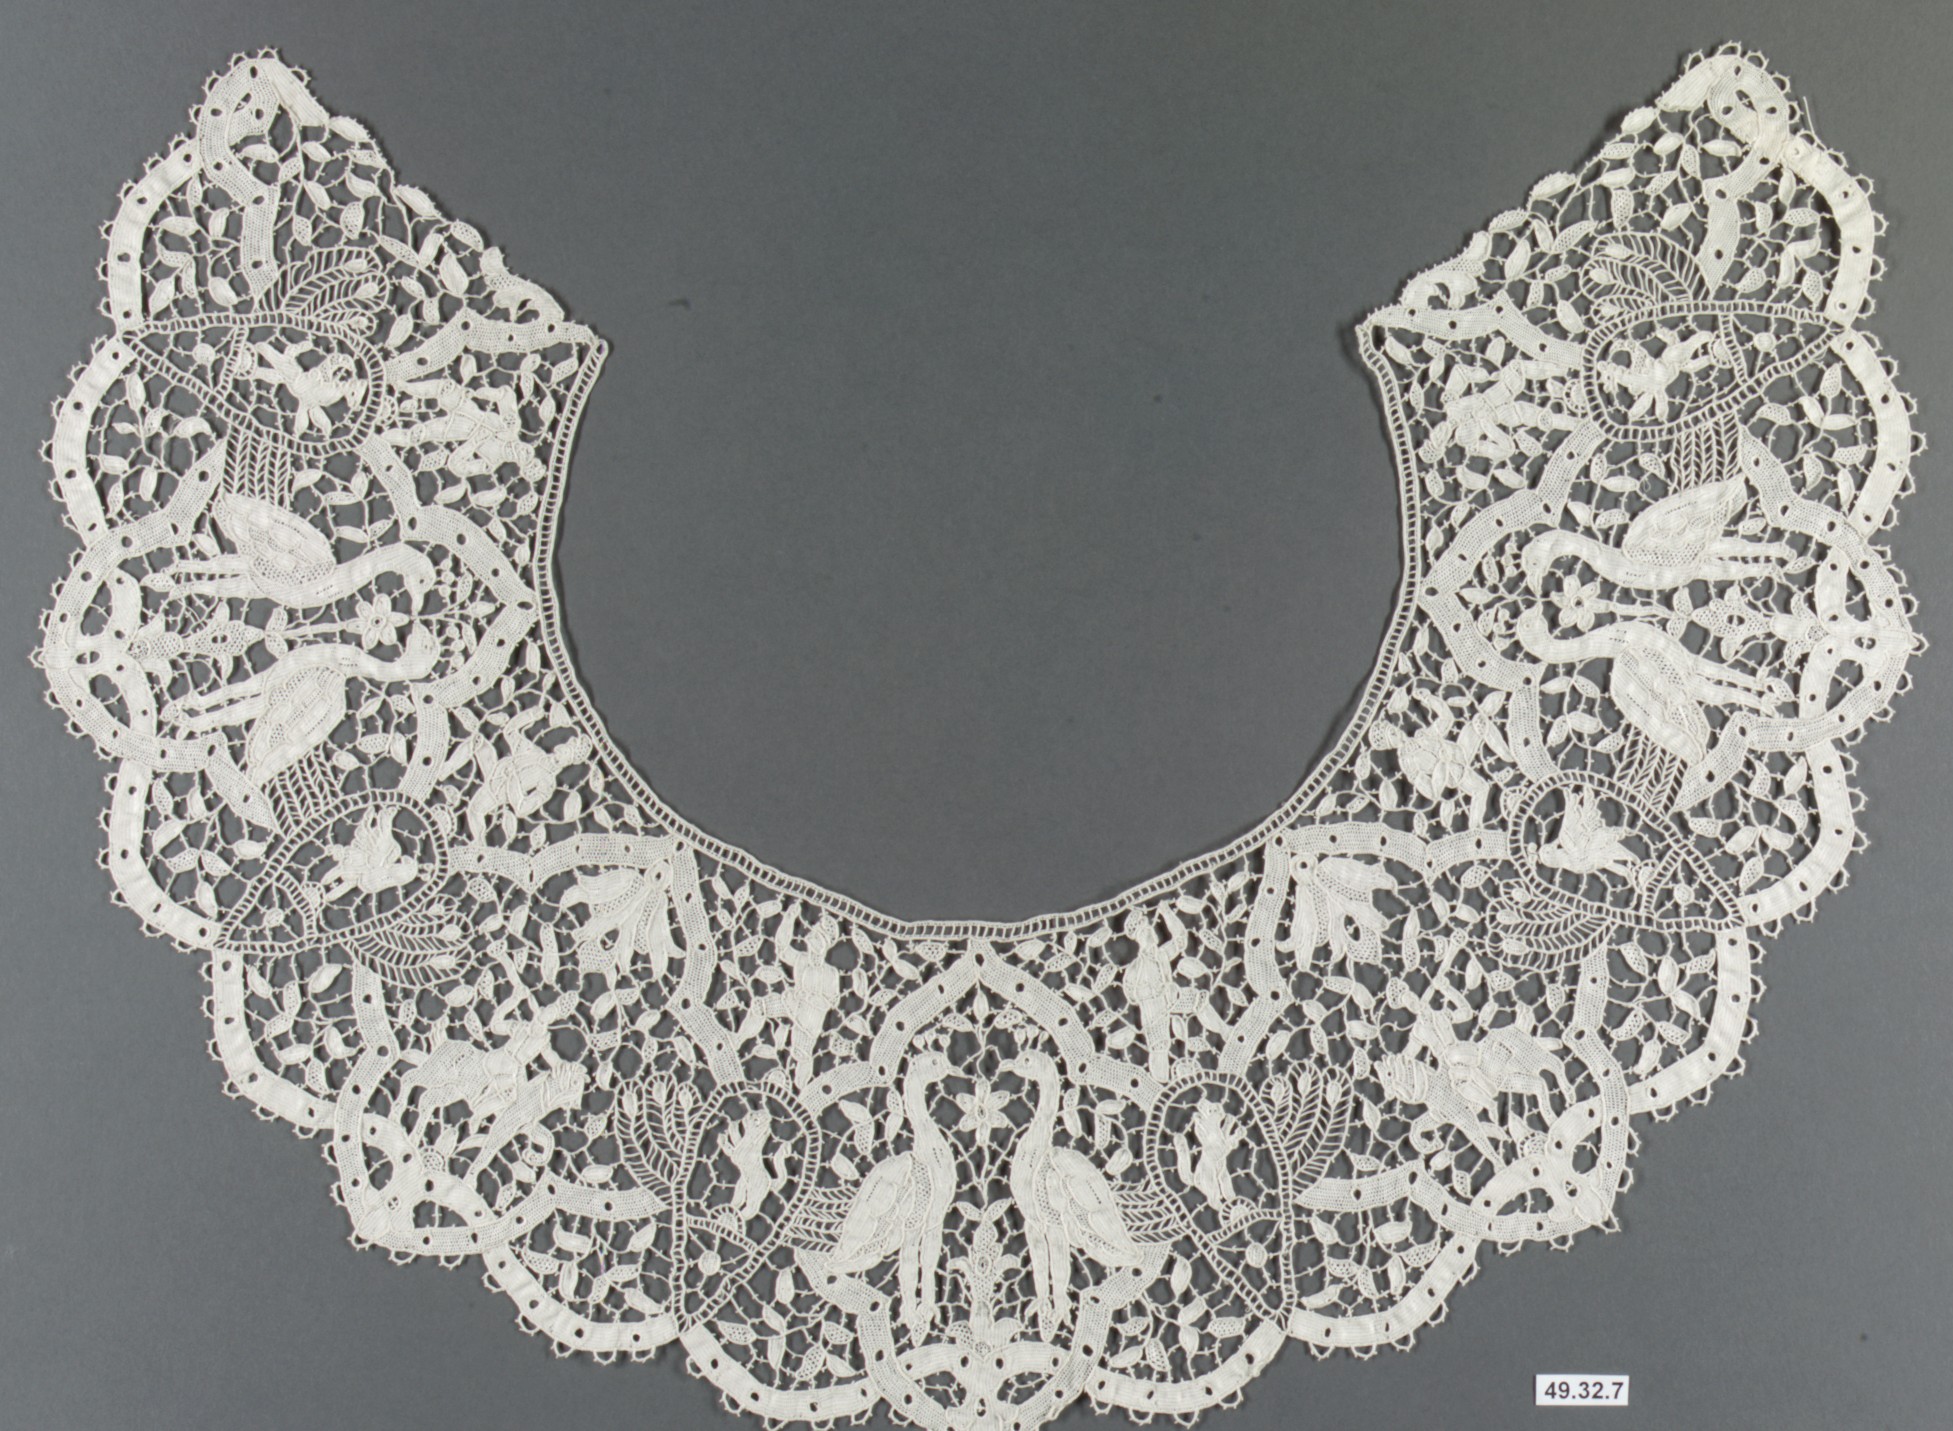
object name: collar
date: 1801-1900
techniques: lace